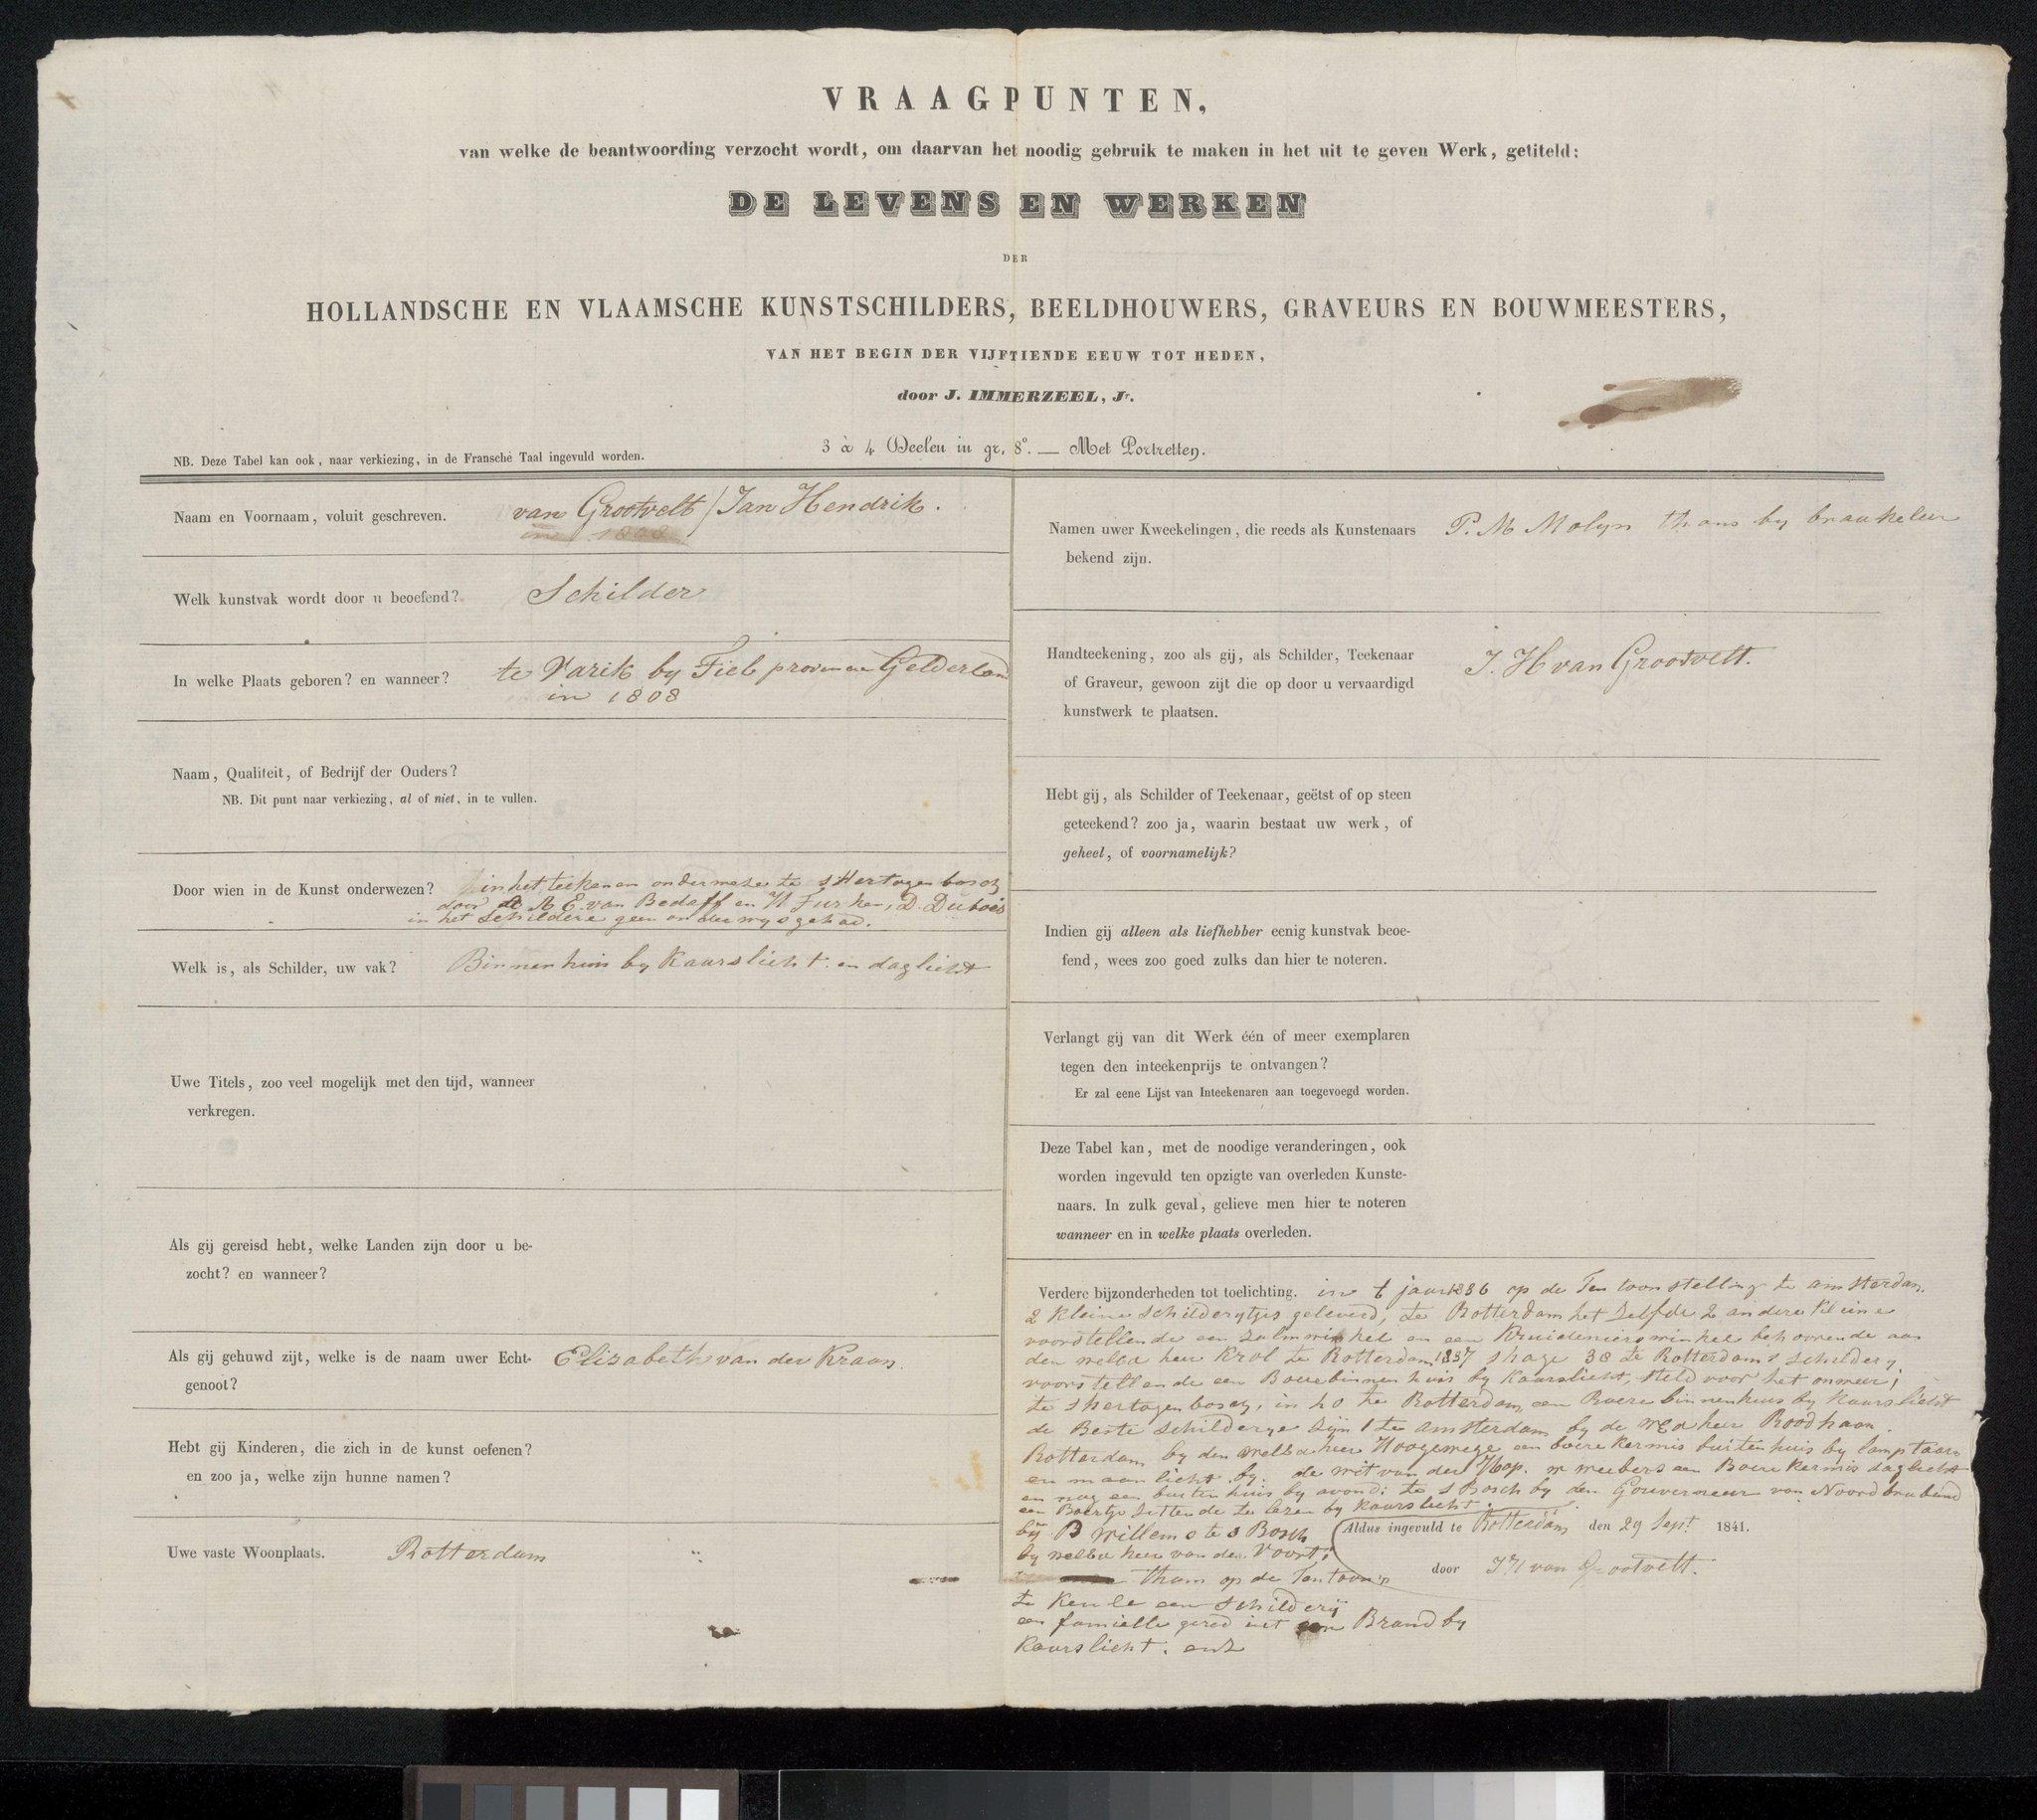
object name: manuscript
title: Enquêteformulier ingevuld door Jan Hendrik van Grootvelt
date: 1841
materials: ink, paper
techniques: pen, printing, writing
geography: rotterdam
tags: painter, draughtsman, jan hendrik van grootvelt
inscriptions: inscription: ‘Vraagpunten,/ van welke de beantwoording verzocht wordt, om daarvan het noodig gebruik te maken in het uit te geven Werk, getiteld: De levens en werken/ der Hollandsche en Vlaamsche kunstschilders, beeldhouwers,/ graveurs en bouwmeesters, van het begin der vijftiende eeuw tot heden/ door J. Immerzeel, Jr.’, watermark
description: Opgenomen in: Immerzeel, J. Jr., De levens en werken der Hollandsche en Vlaamsche kunstschilders, beeldhouwers, graveurs en bouwmeesters, van het begin der vijftiende eeuw tot heden, Amsterdam: J.C. van Kesteren, 1842-1843.